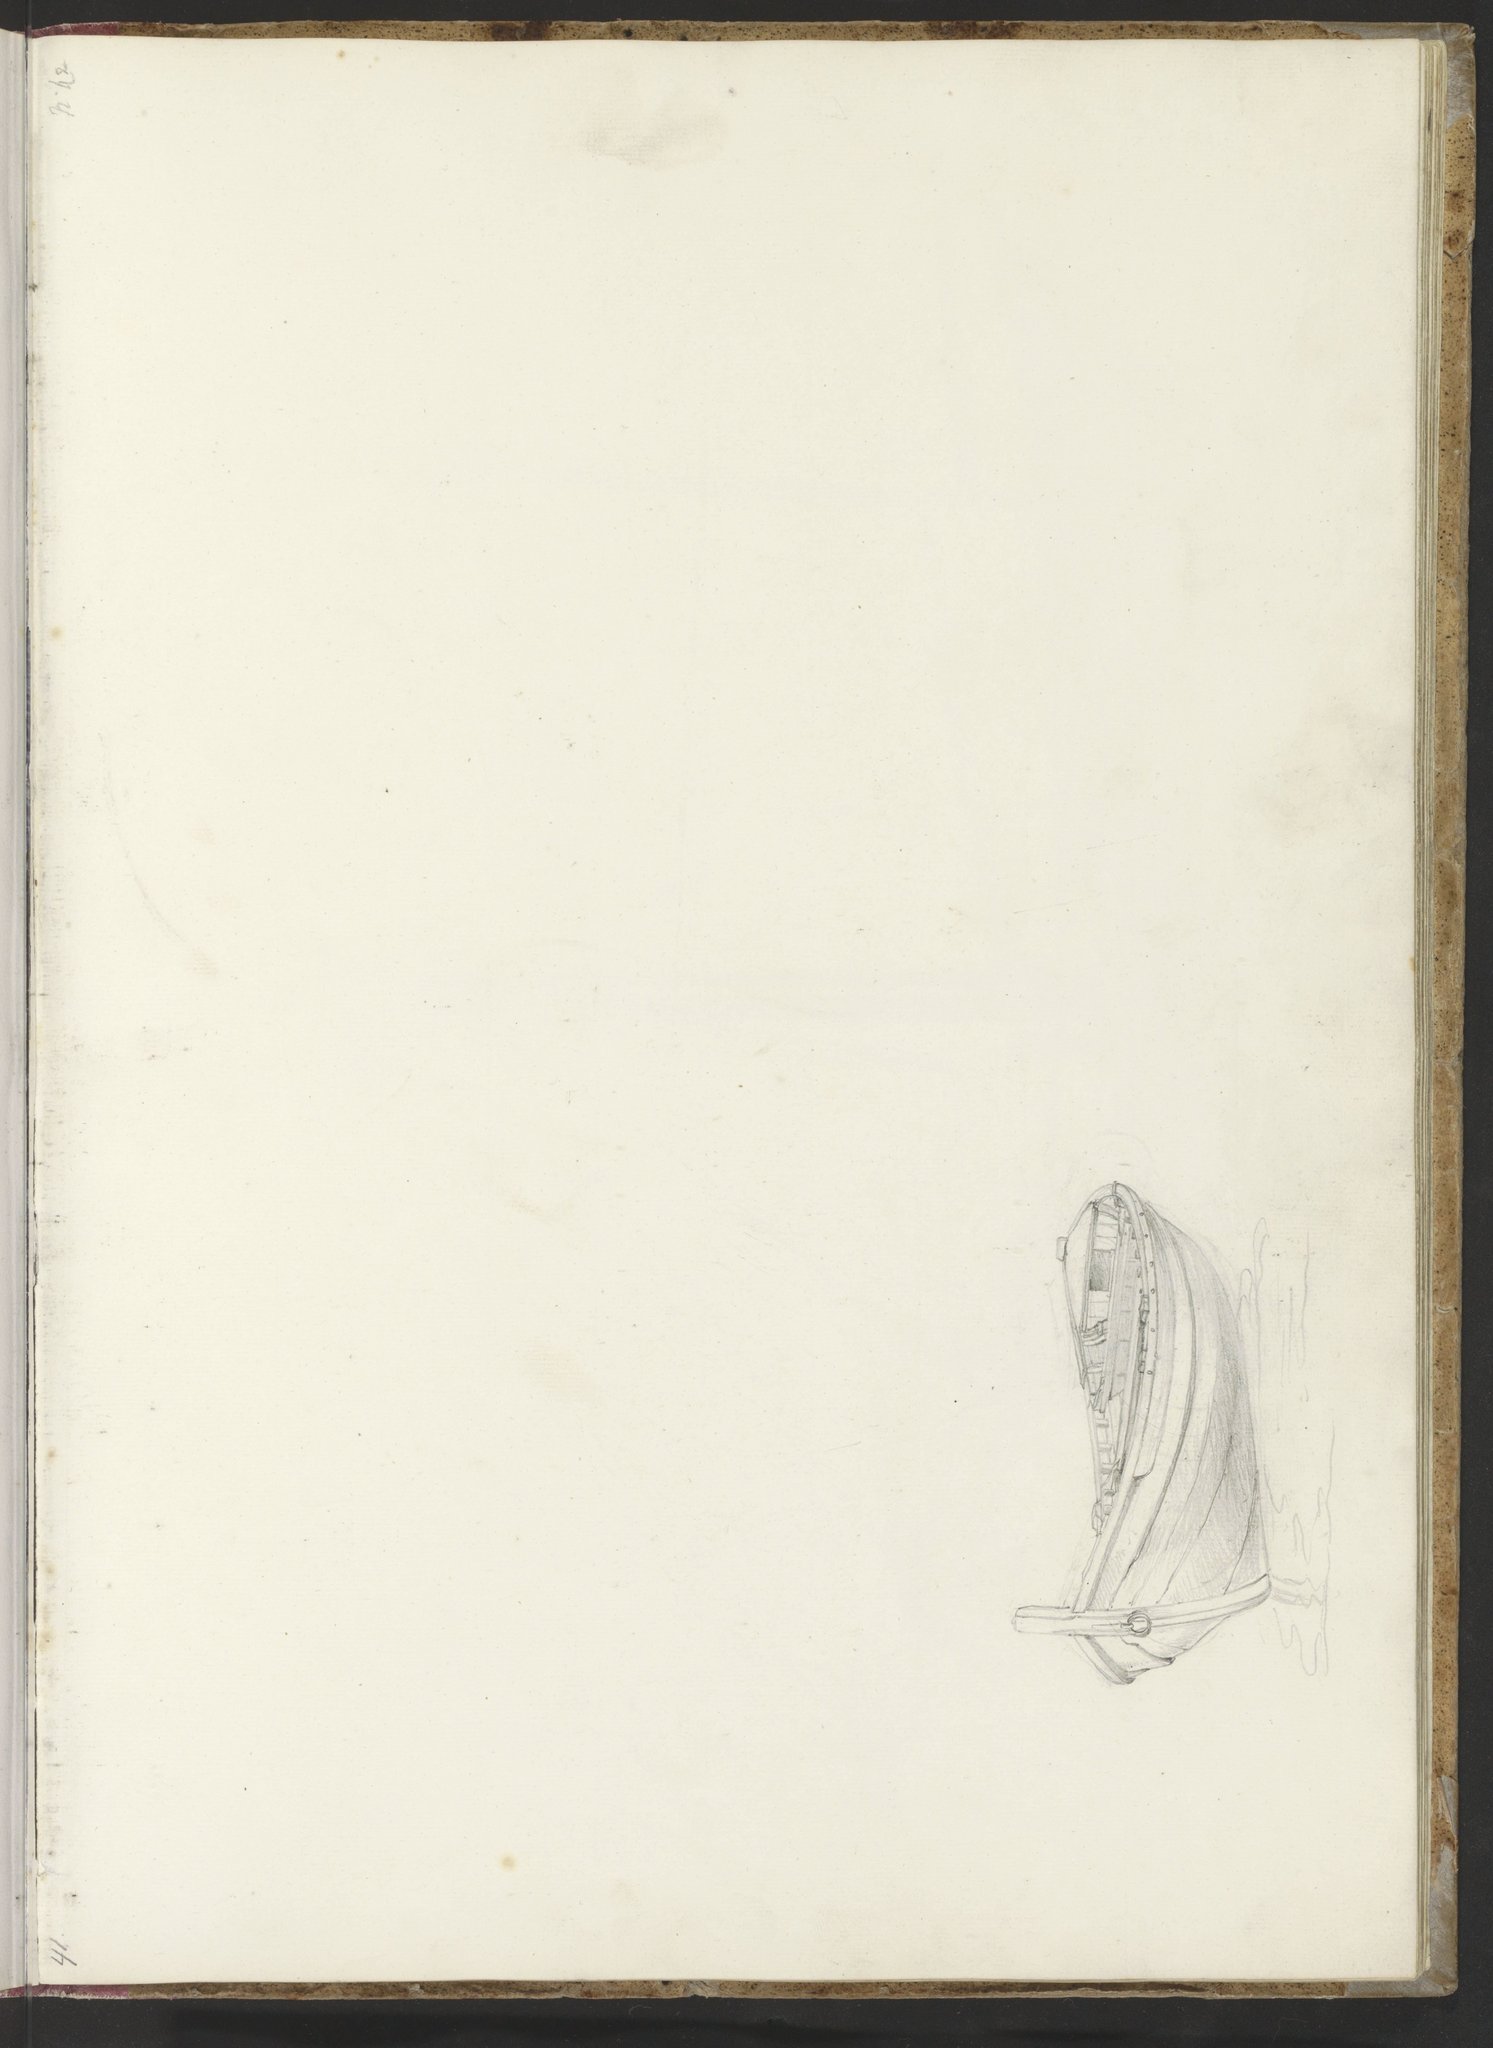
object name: sketchbook leaf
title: Boot op het water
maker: johannes christiaan schotel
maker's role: draughtsman, painter, print maker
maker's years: 1787-1838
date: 1797-1838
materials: paper, pencil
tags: sailing-ship, sailing-boat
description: Blad 41 recto uit een schetsboek met 65 bladen.